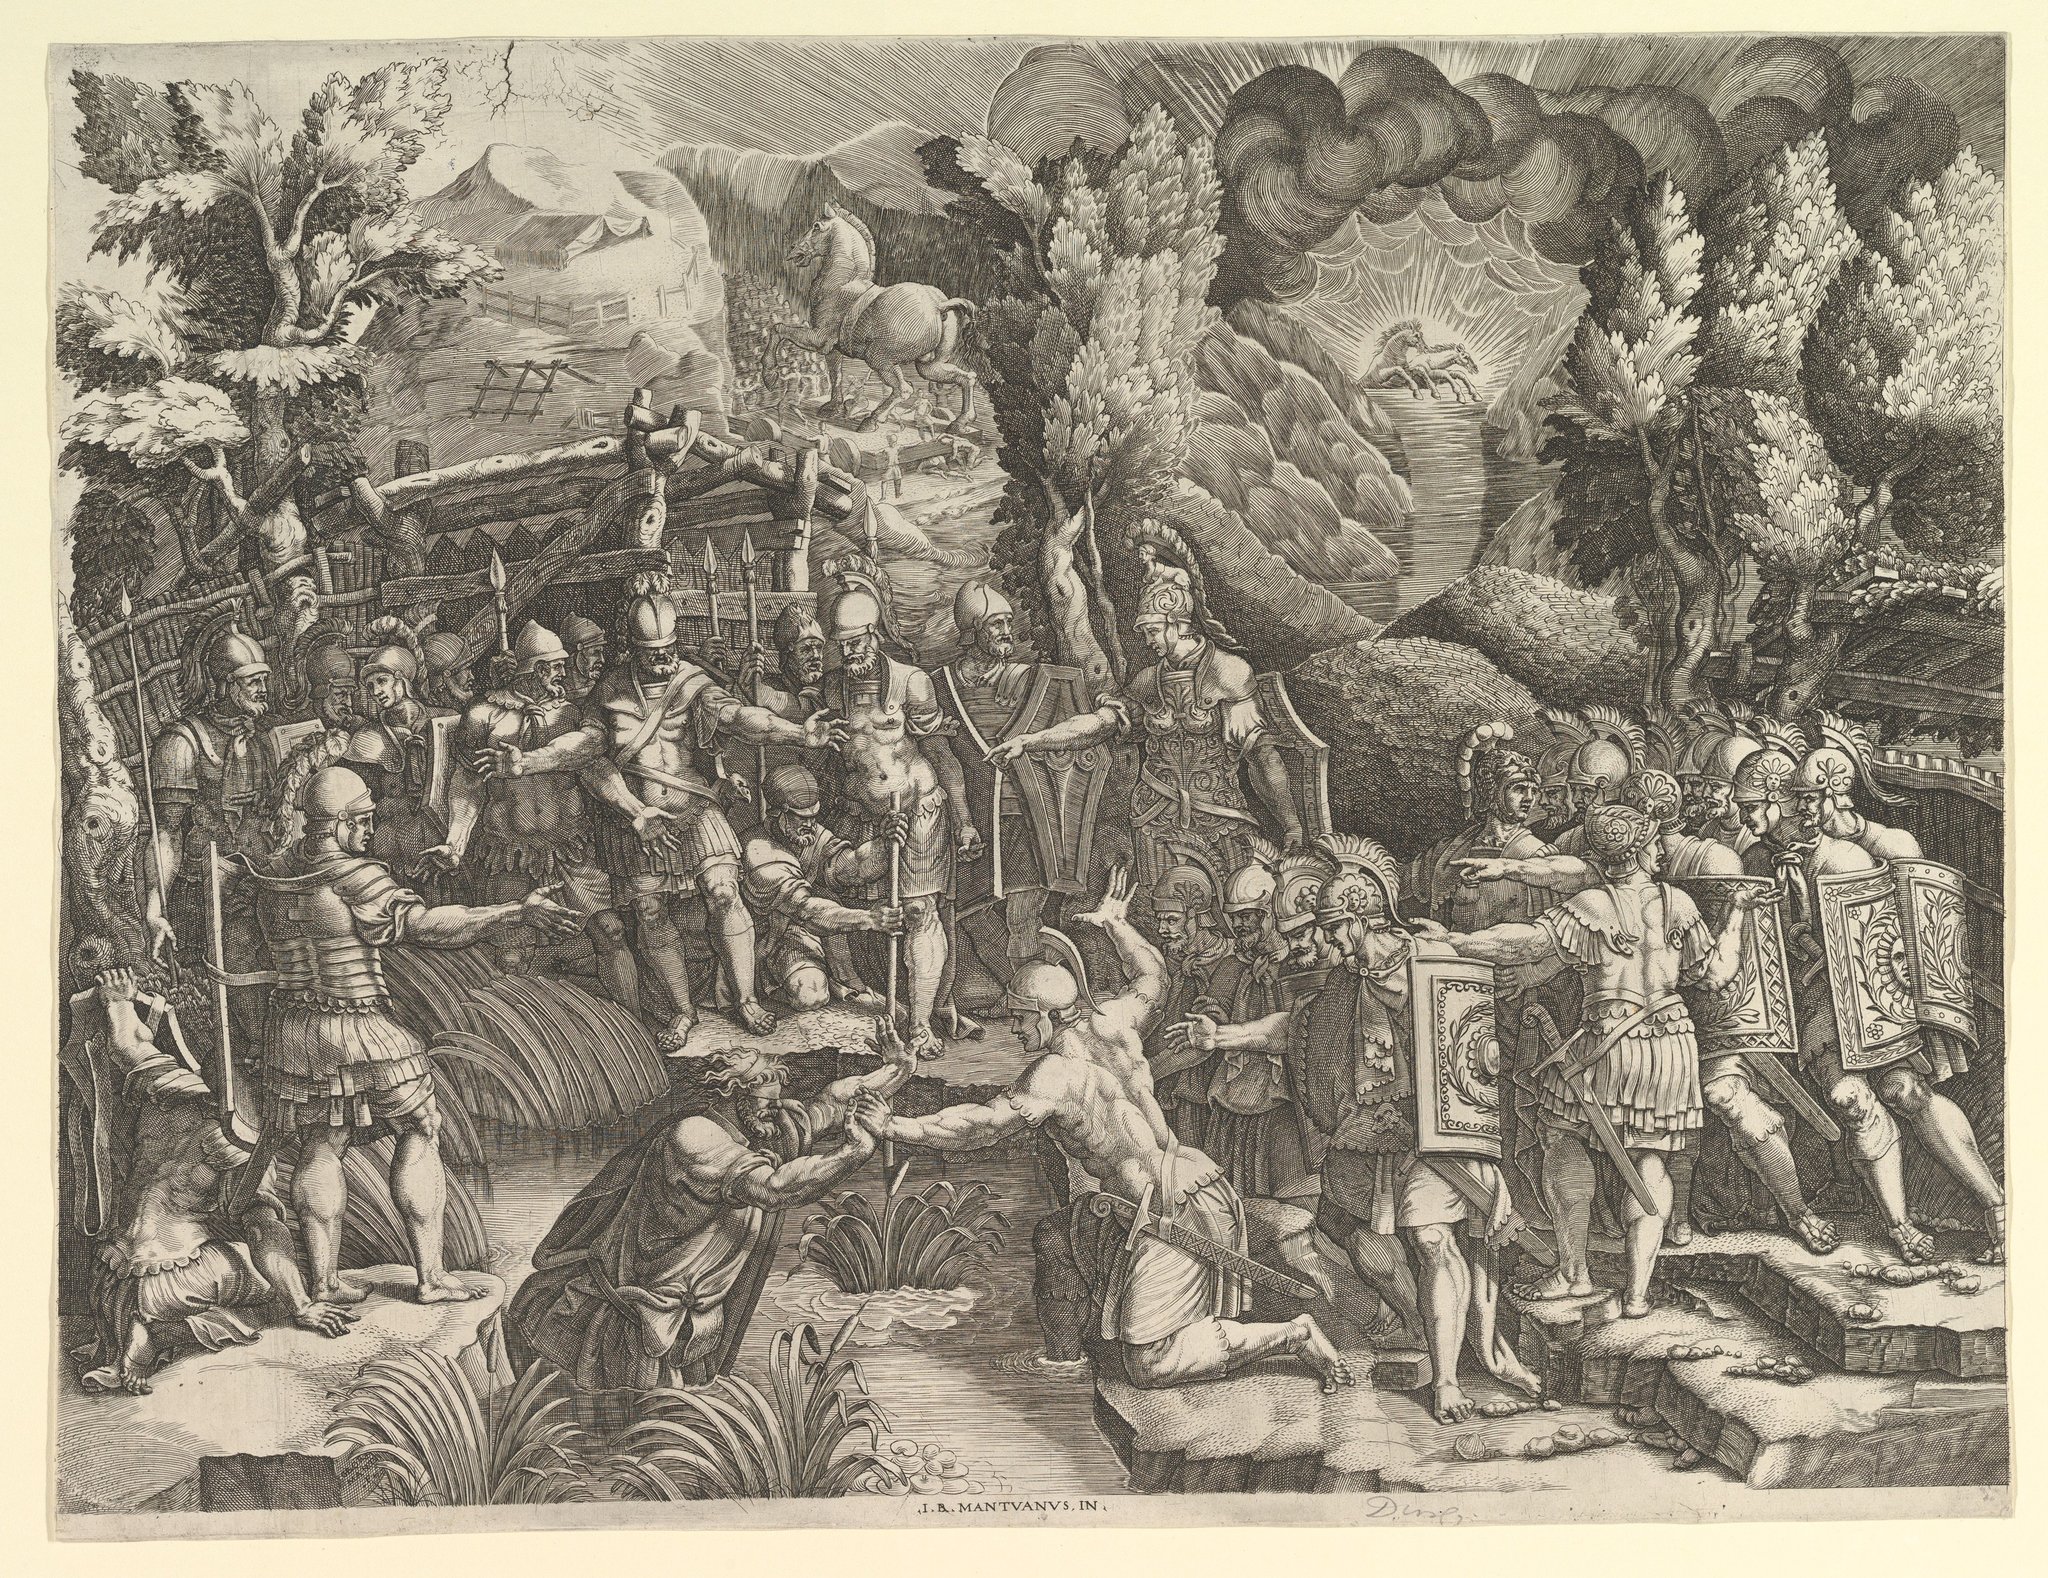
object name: print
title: Sinon Deceiving the Trojans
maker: giorgio ghisi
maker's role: artist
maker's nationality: italian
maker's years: 1515-1582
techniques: engraving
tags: battles,soldiers,men